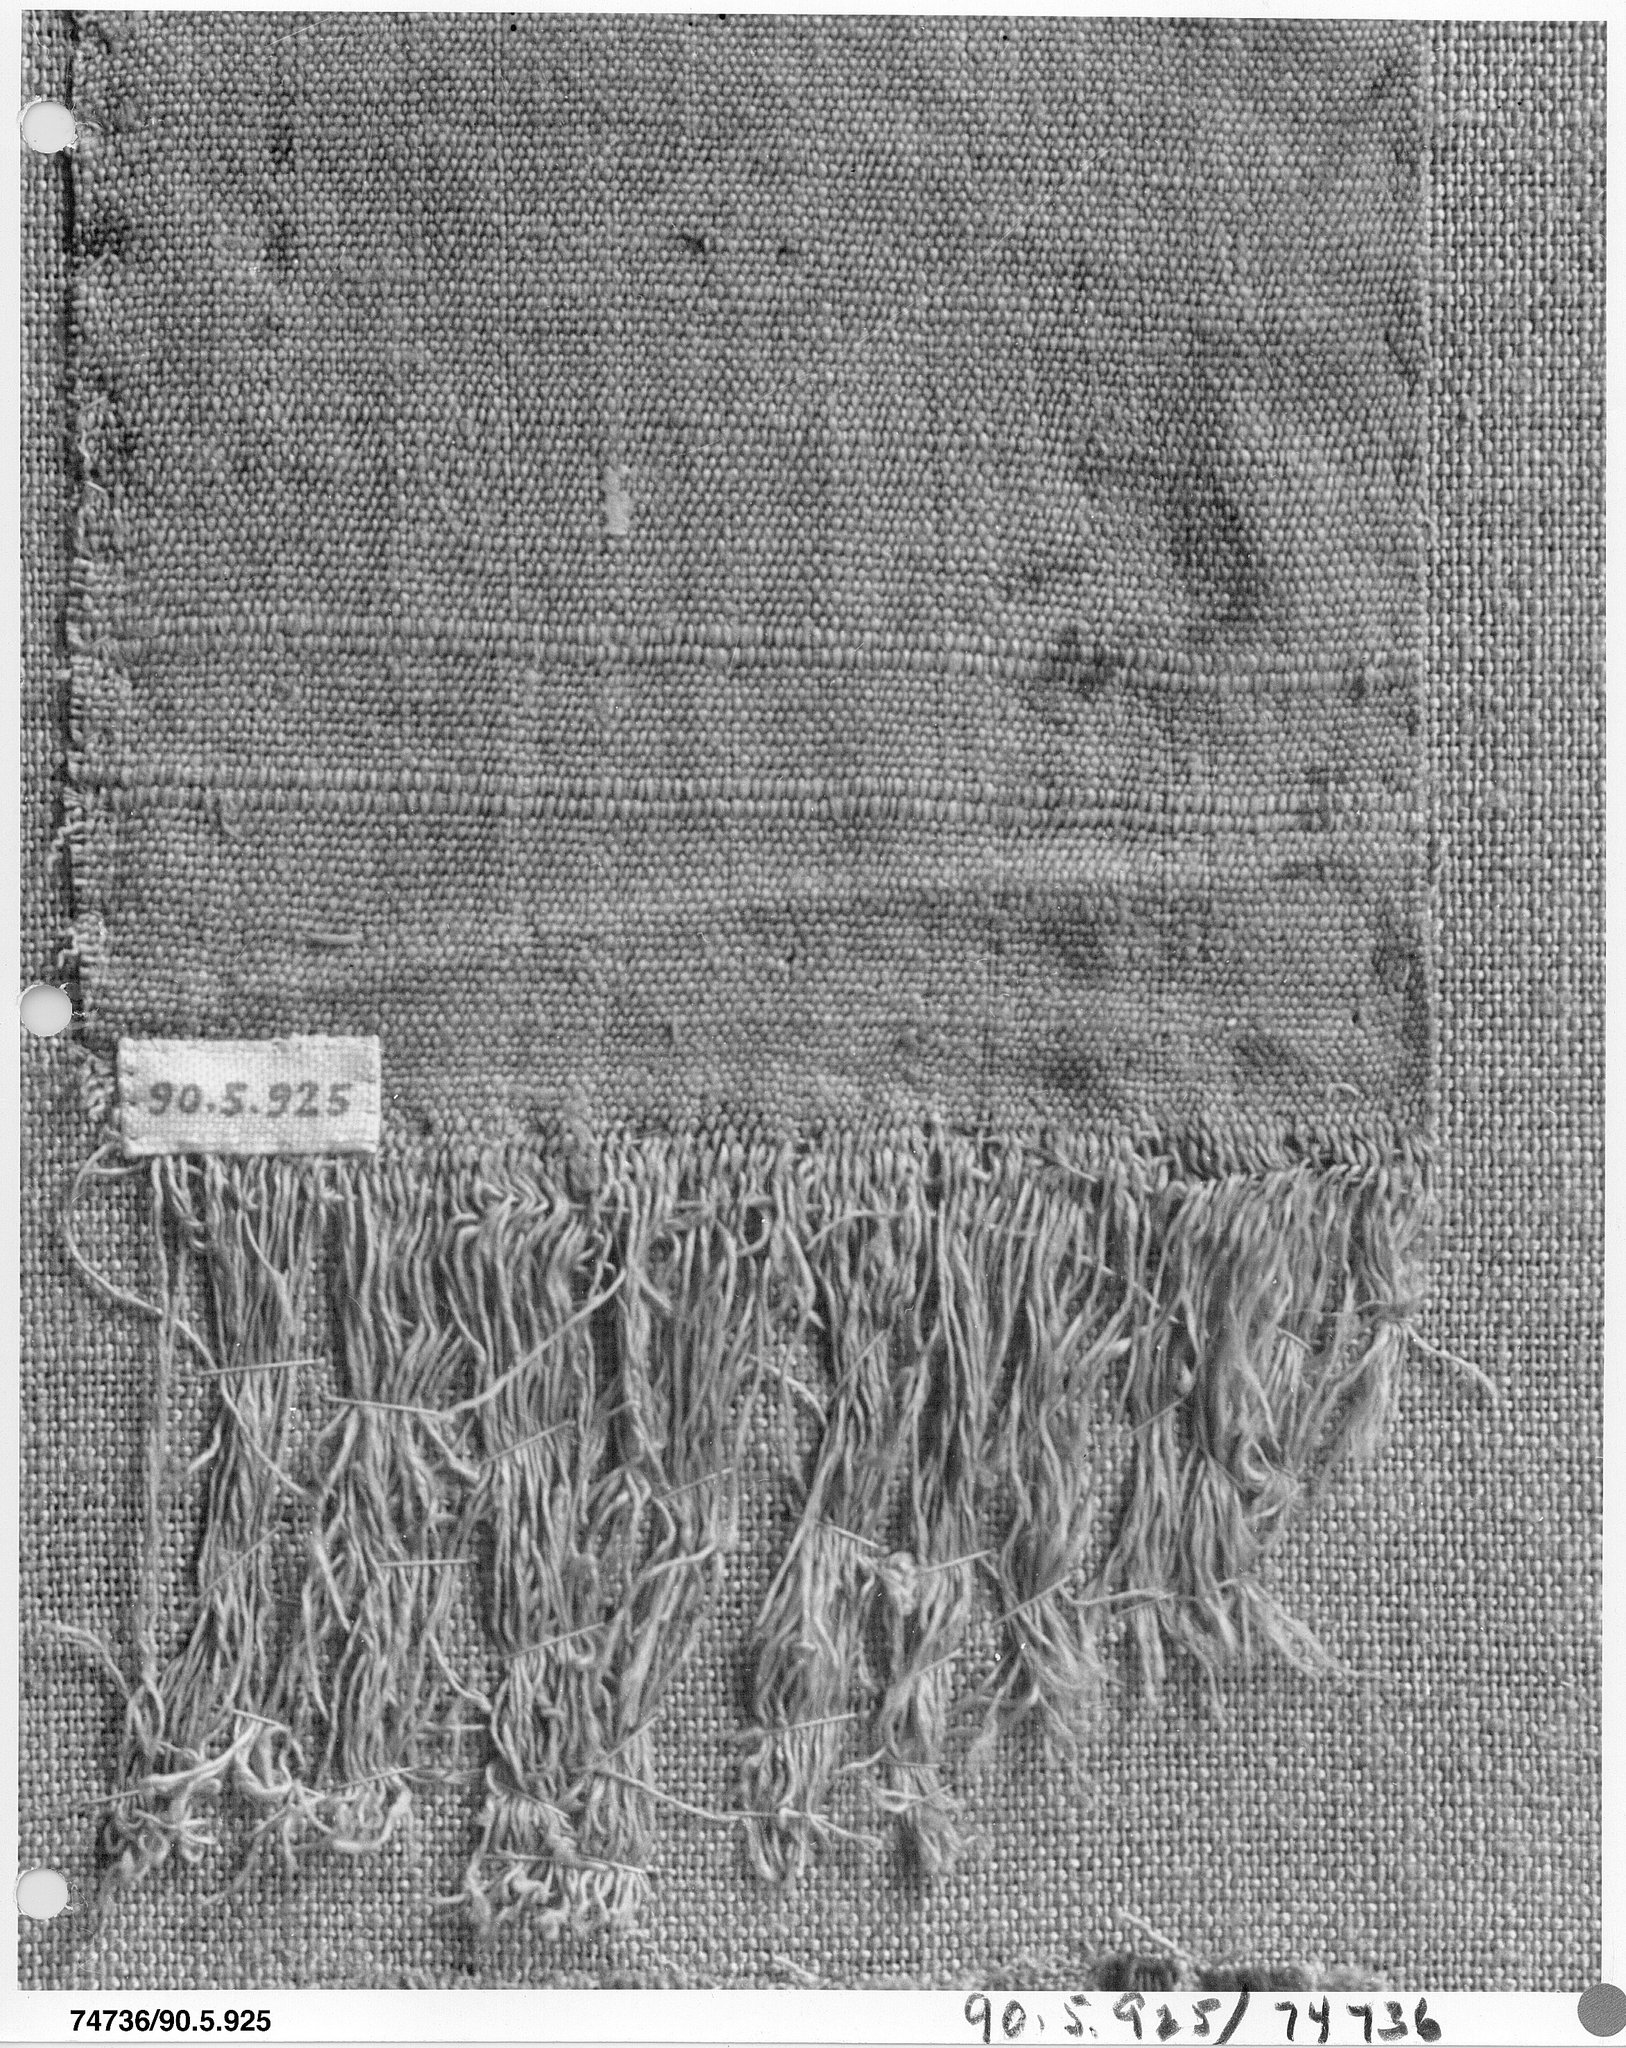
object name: textile fragment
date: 201-400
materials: linen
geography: egypt